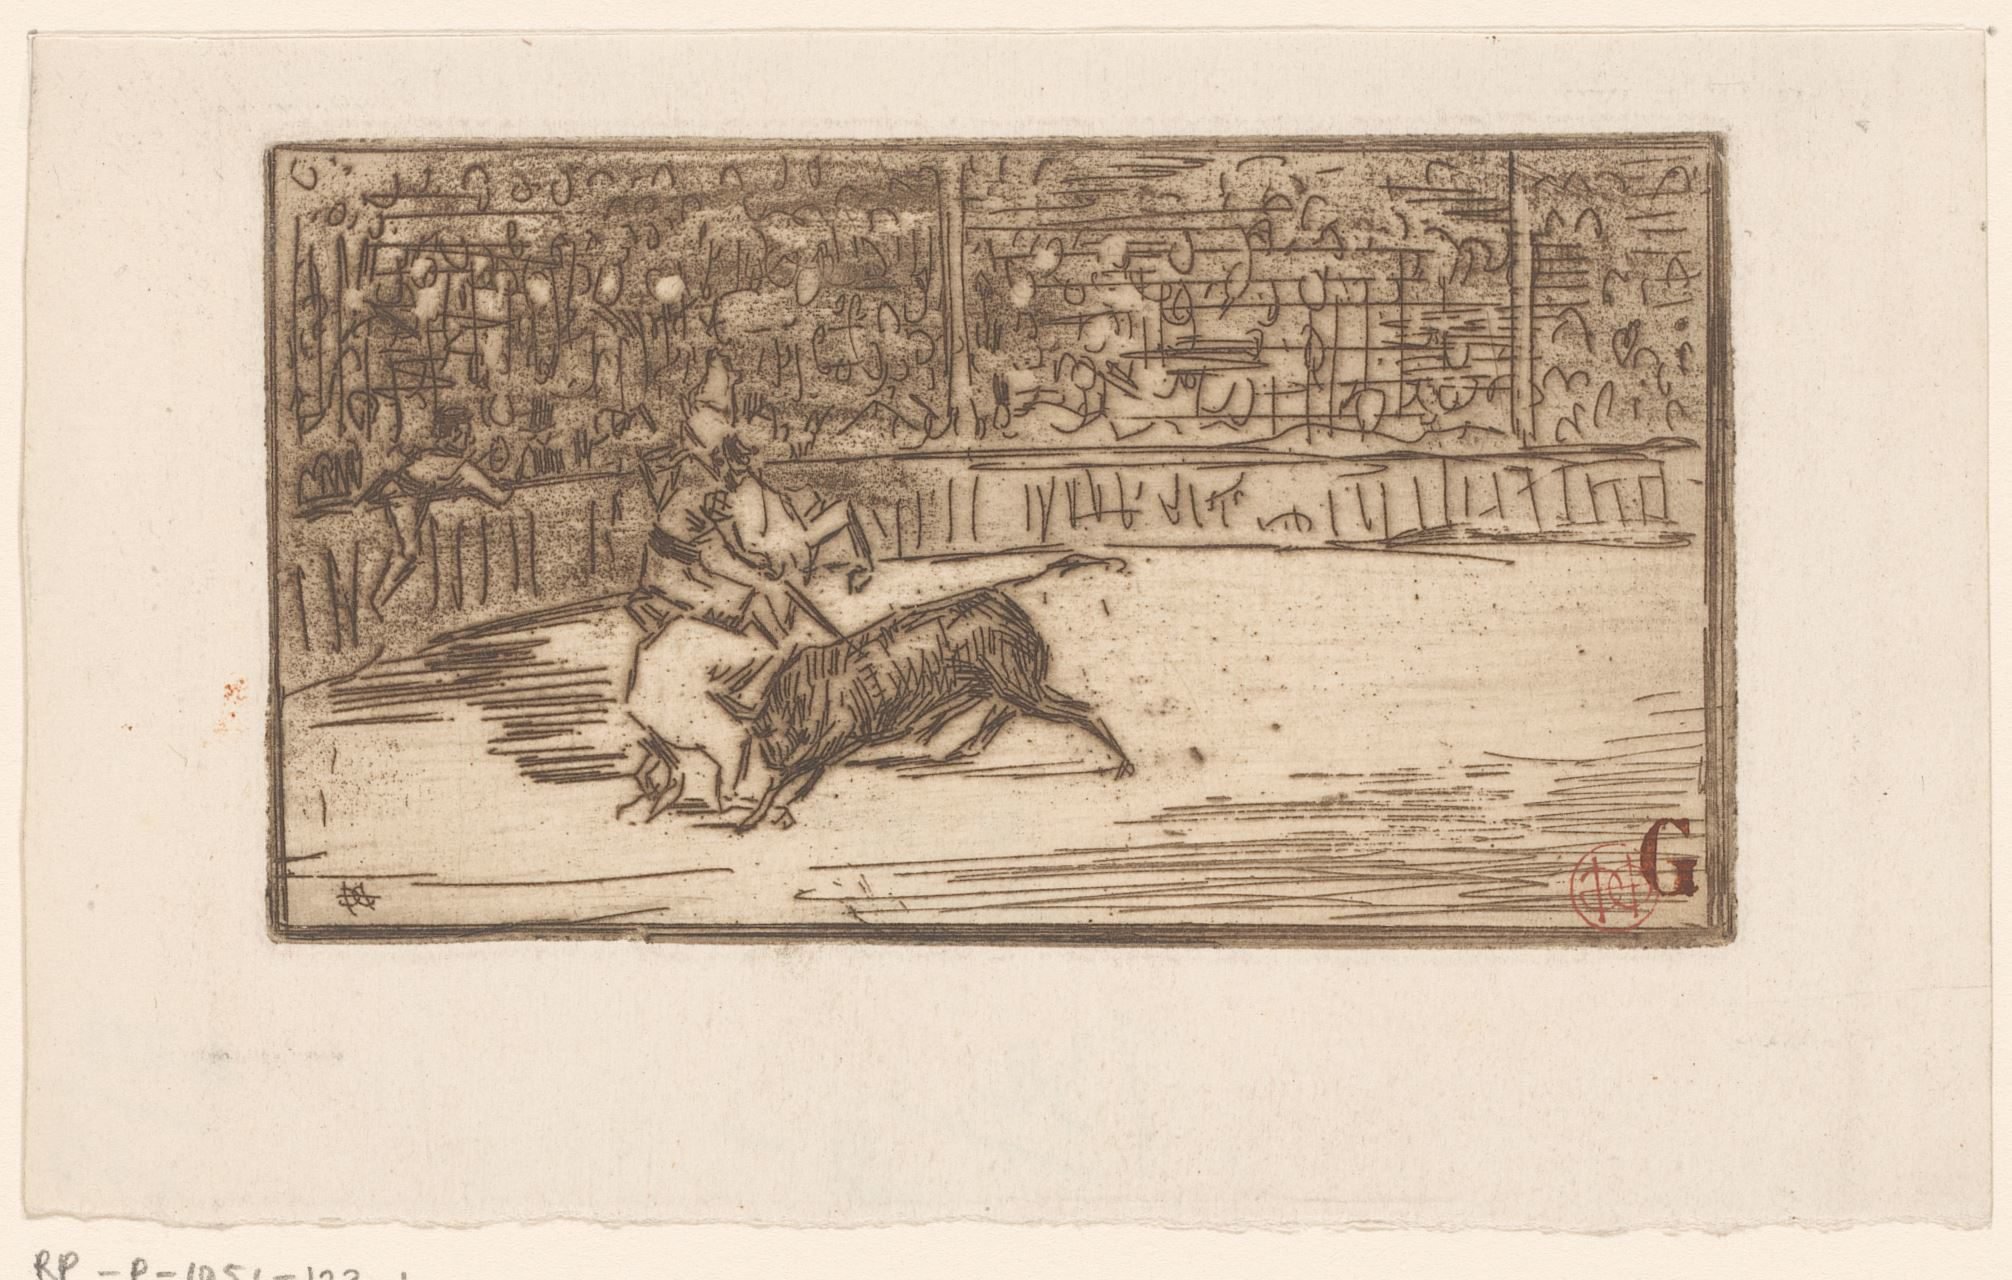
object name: print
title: Stierenvechter in een arena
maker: henri charles guérard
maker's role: print maker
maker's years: 1846-1897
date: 1856-1897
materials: paper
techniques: aquatint, etching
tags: bull-fighter, toreador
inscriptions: collector's mark: Lugt 2228, collector's mark: Lugt 1120b, stamp: Lugt 1157